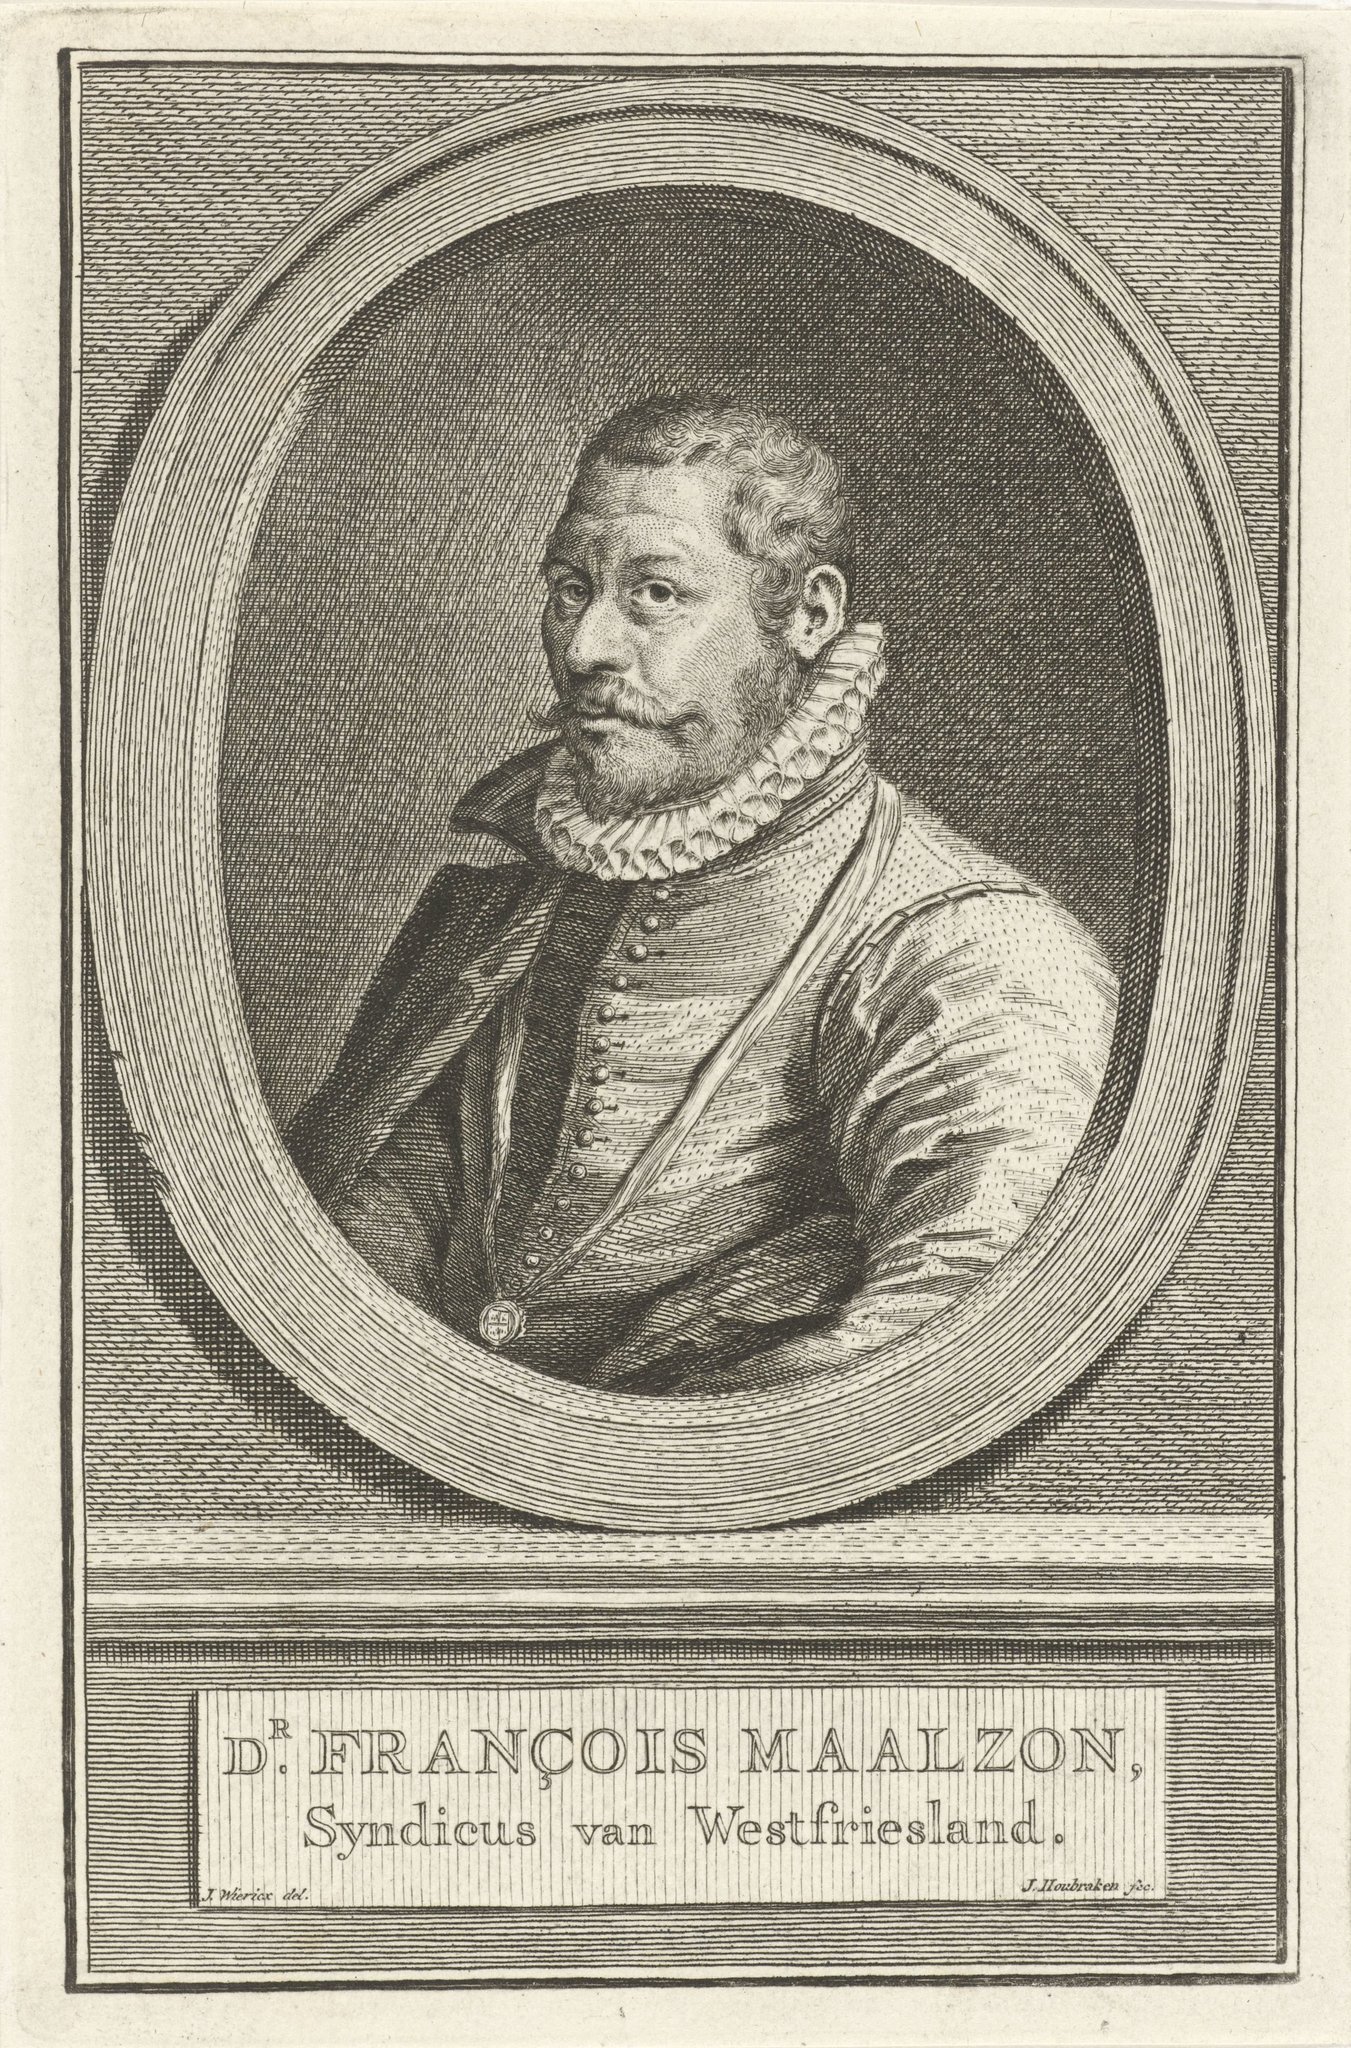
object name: print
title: Dr. François Maalzon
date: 1790-1796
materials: paper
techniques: engraving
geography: amsterdam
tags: staatsman, medicus, françois maelson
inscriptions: collector's mark: Lugt 2228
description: Prent oorspronkelijk gebruikt in: Jan Wagenaar, Vaderlandsche historie, vervattende de geschiedenissen der nu Vereenigde Nederlanden, inzonderheid die van Holland (...), 21 delen. Amsterdam, Isaak Tirion, 1749-59. Maar hier naam uitgever verwijderd, waarschijnlijk gebruikt in latere editie. Zie Van Someren 8d.